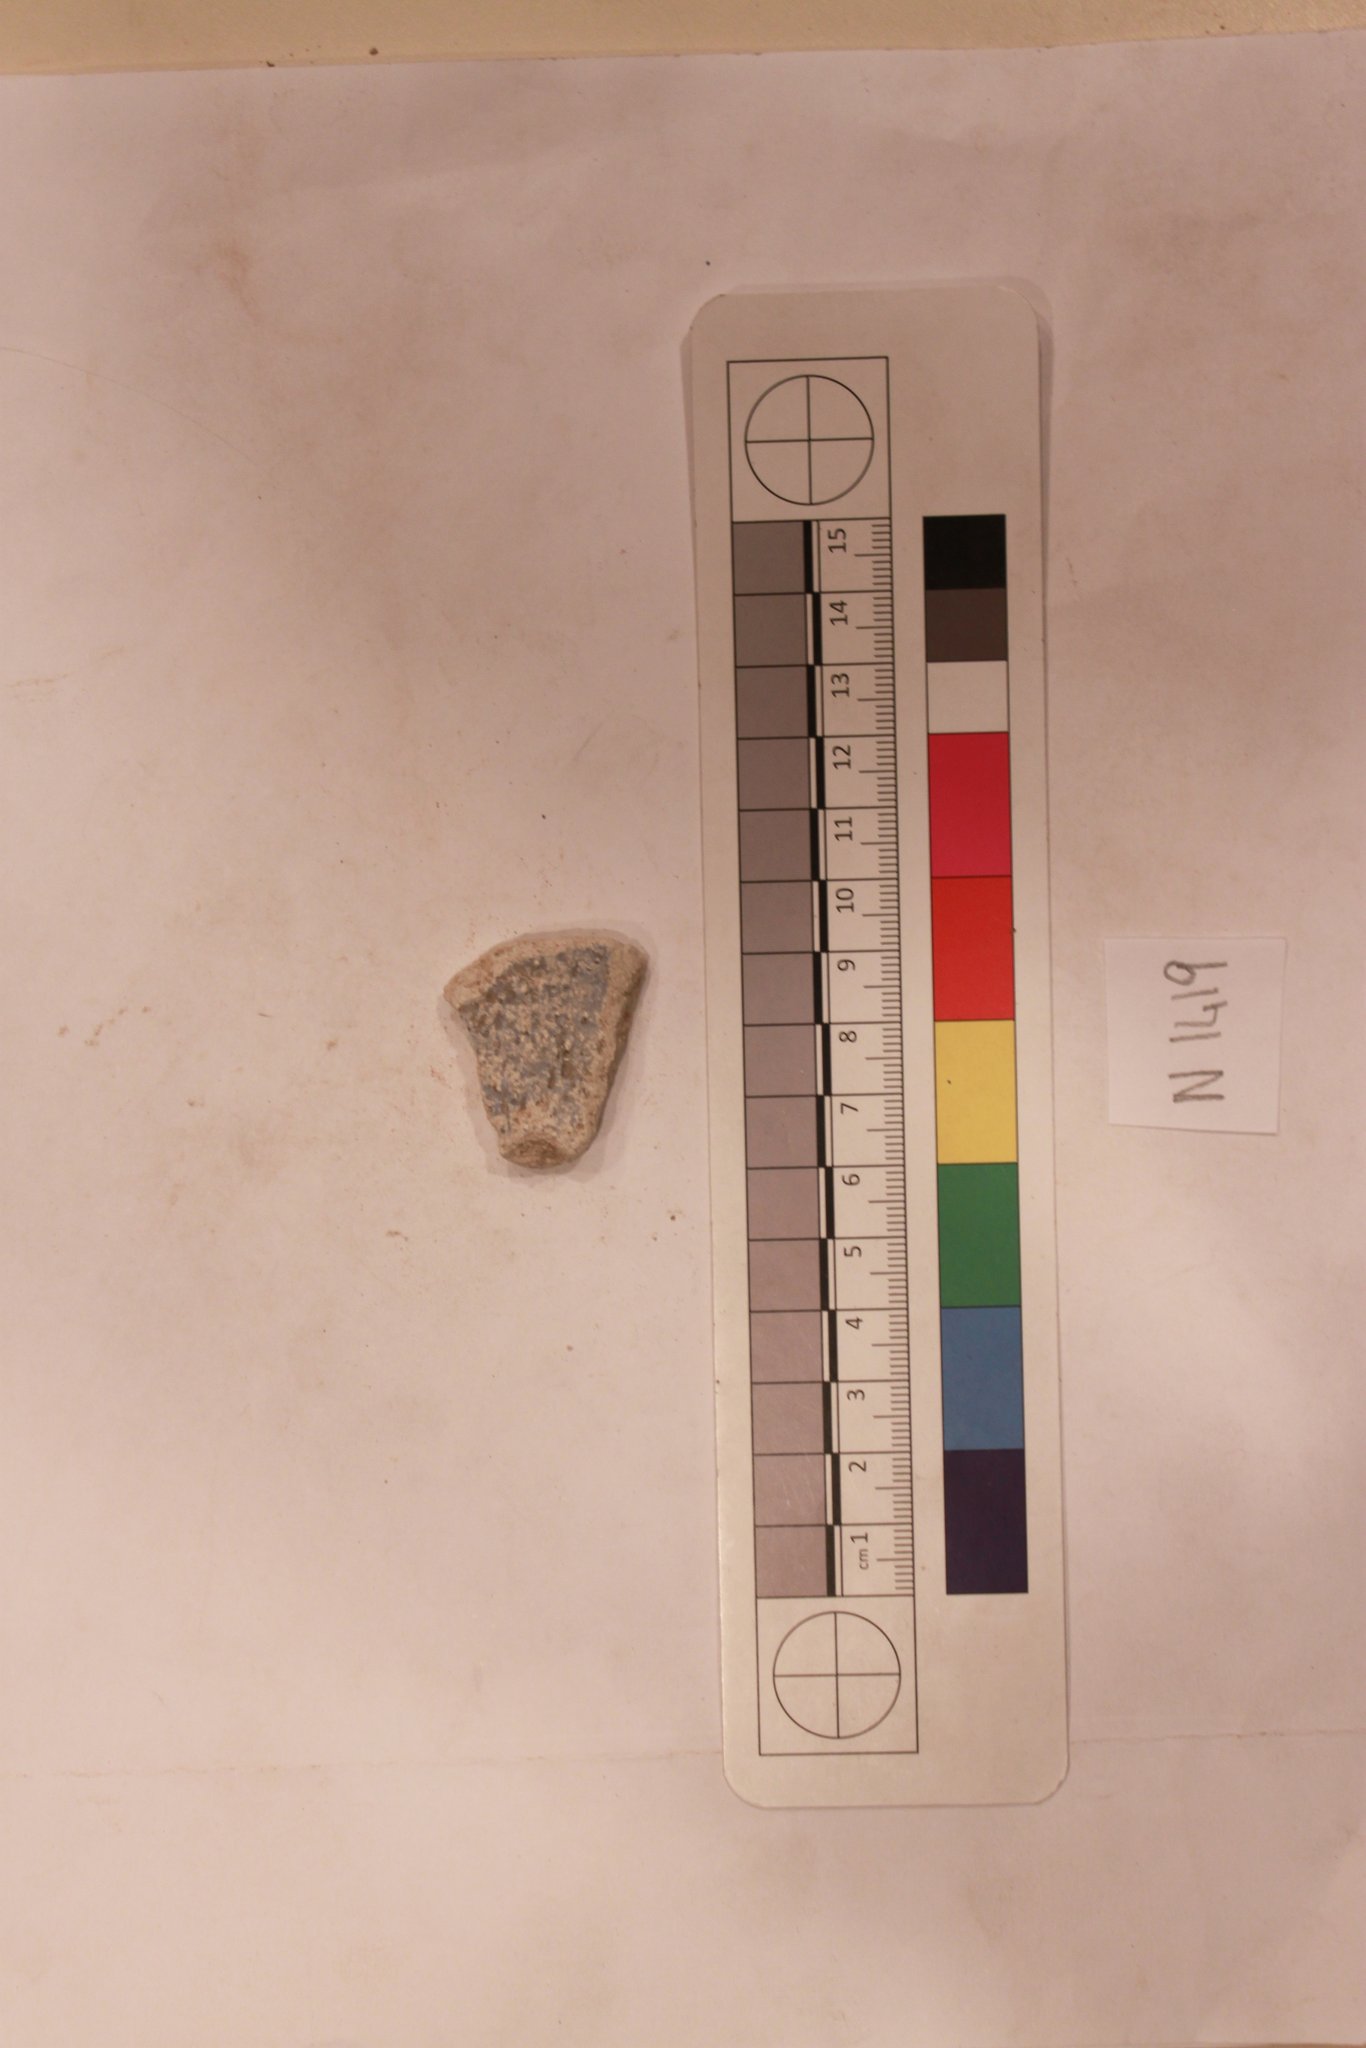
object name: fragment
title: Stucco Fragment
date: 701-1200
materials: plaster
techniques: carving, painting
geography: iran